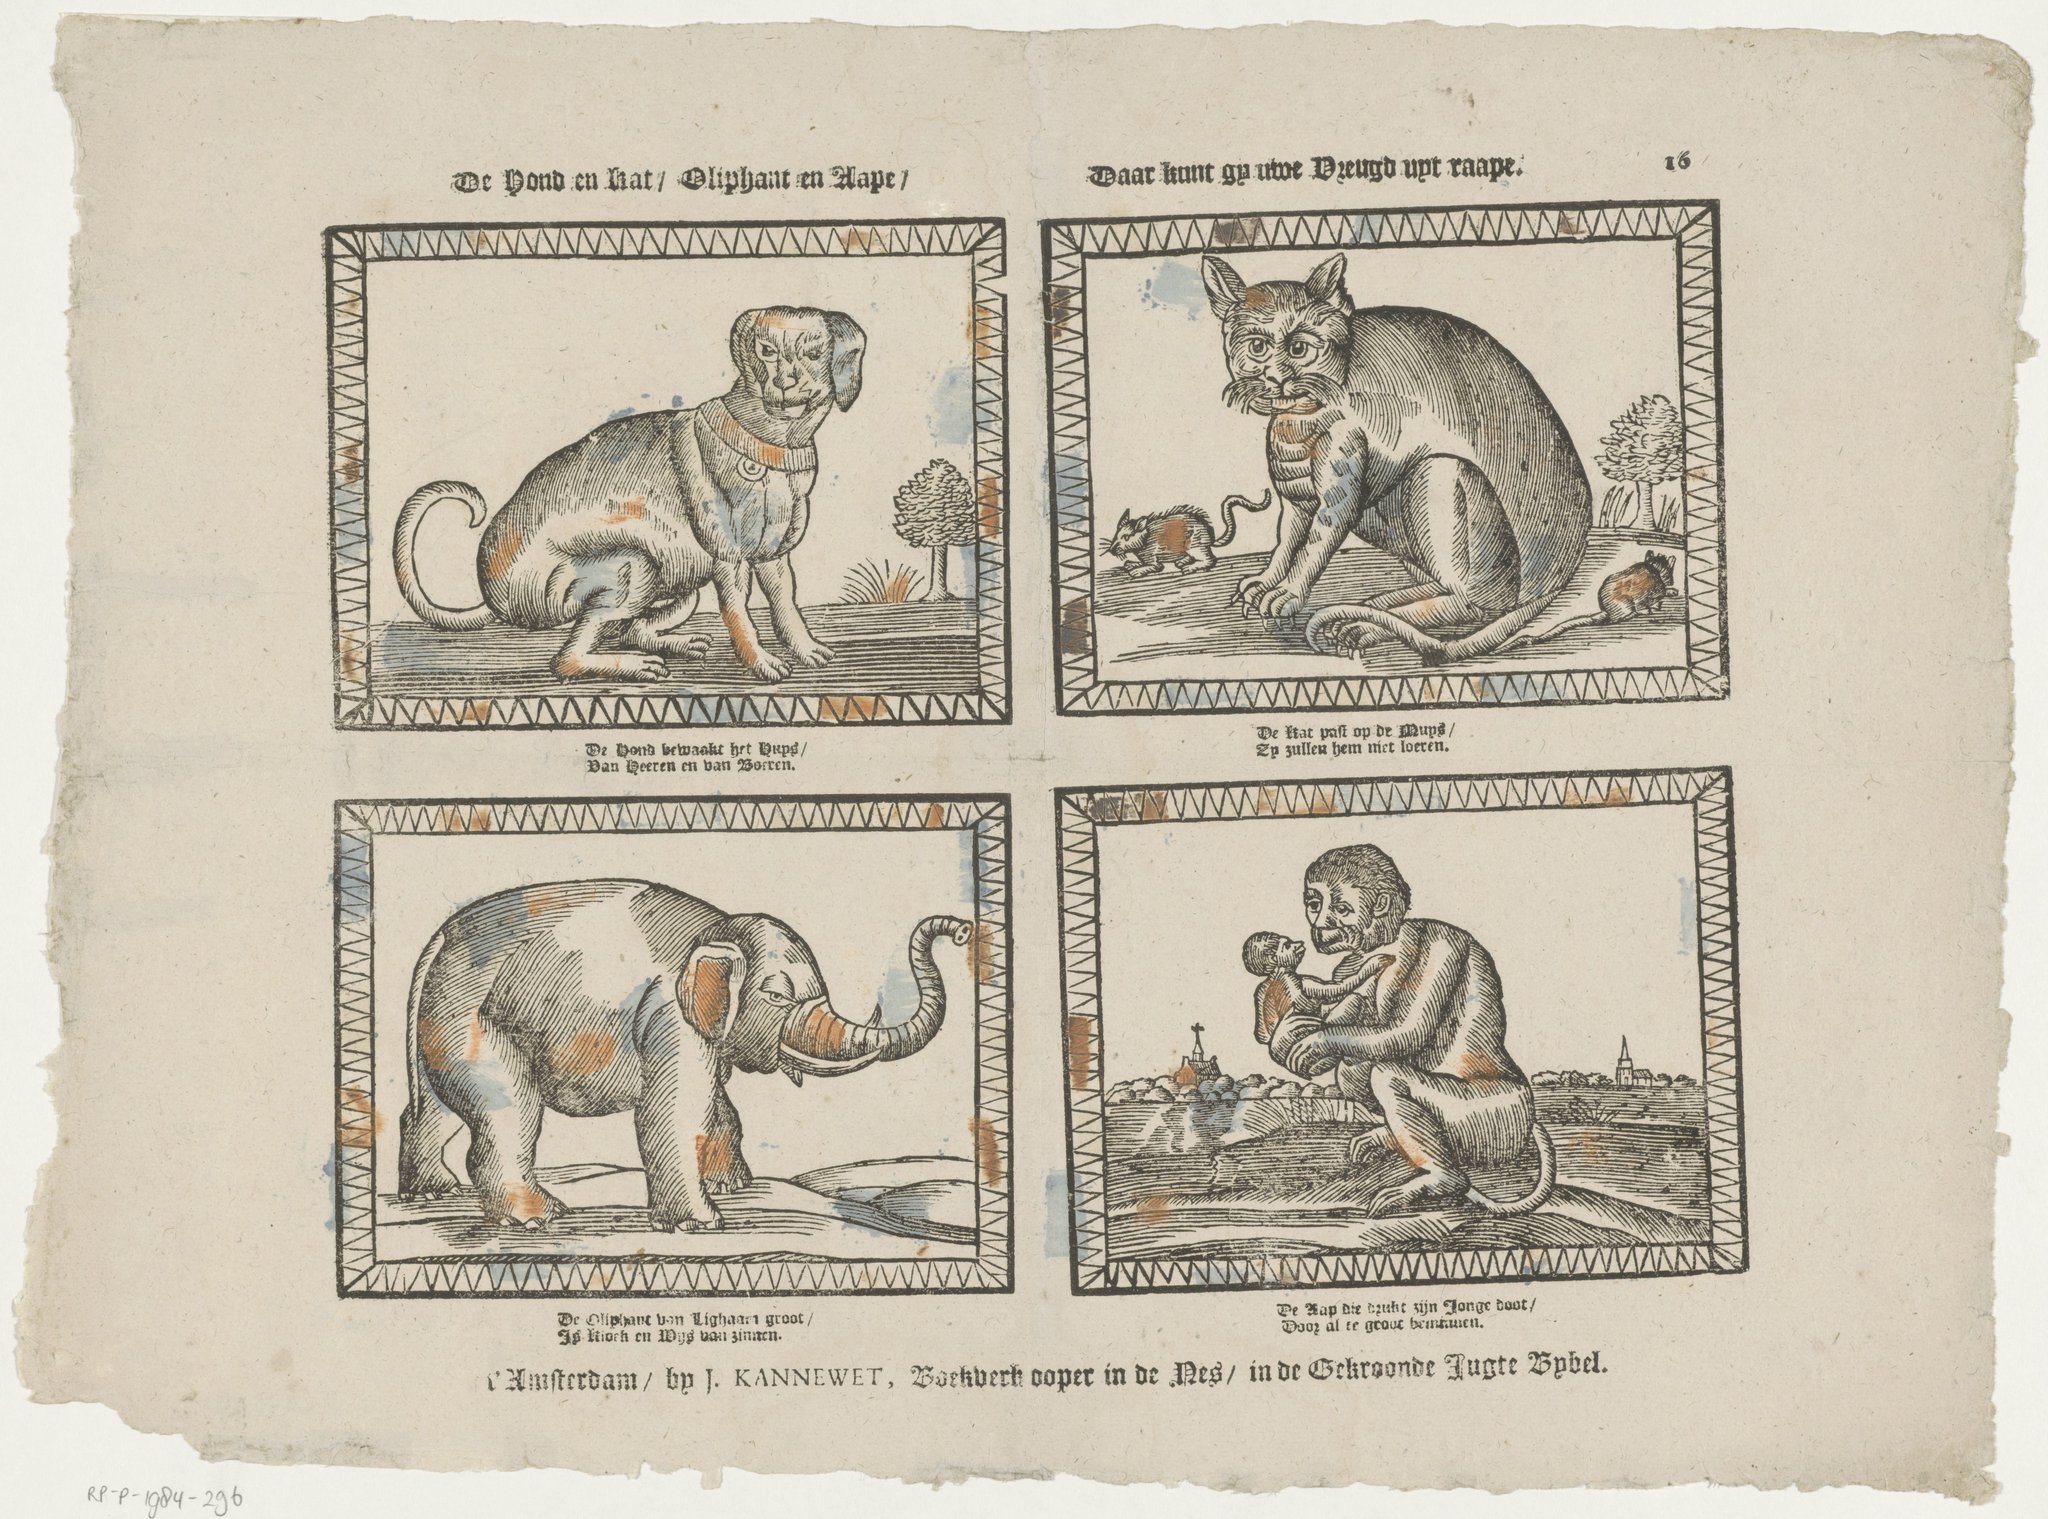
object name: popular print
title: De hond en kat / oliphant en aape / Daar kunt gij uwe vreugt uyt raape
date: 1725-1780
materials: paper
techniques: colour, letterpress printing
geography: amsterdam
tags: animals, cat, monkeys, apes, trunked animals: elephant, dog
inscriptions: collector's mark: Lugt 2228, collector's mark: Lugt 2760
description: Blad met 4 voorstellingen van een hond, een kat, een olifant en een aap. Onder elke afbeelding een tweeregelig vers. Genummerd rechtsboven: 16.